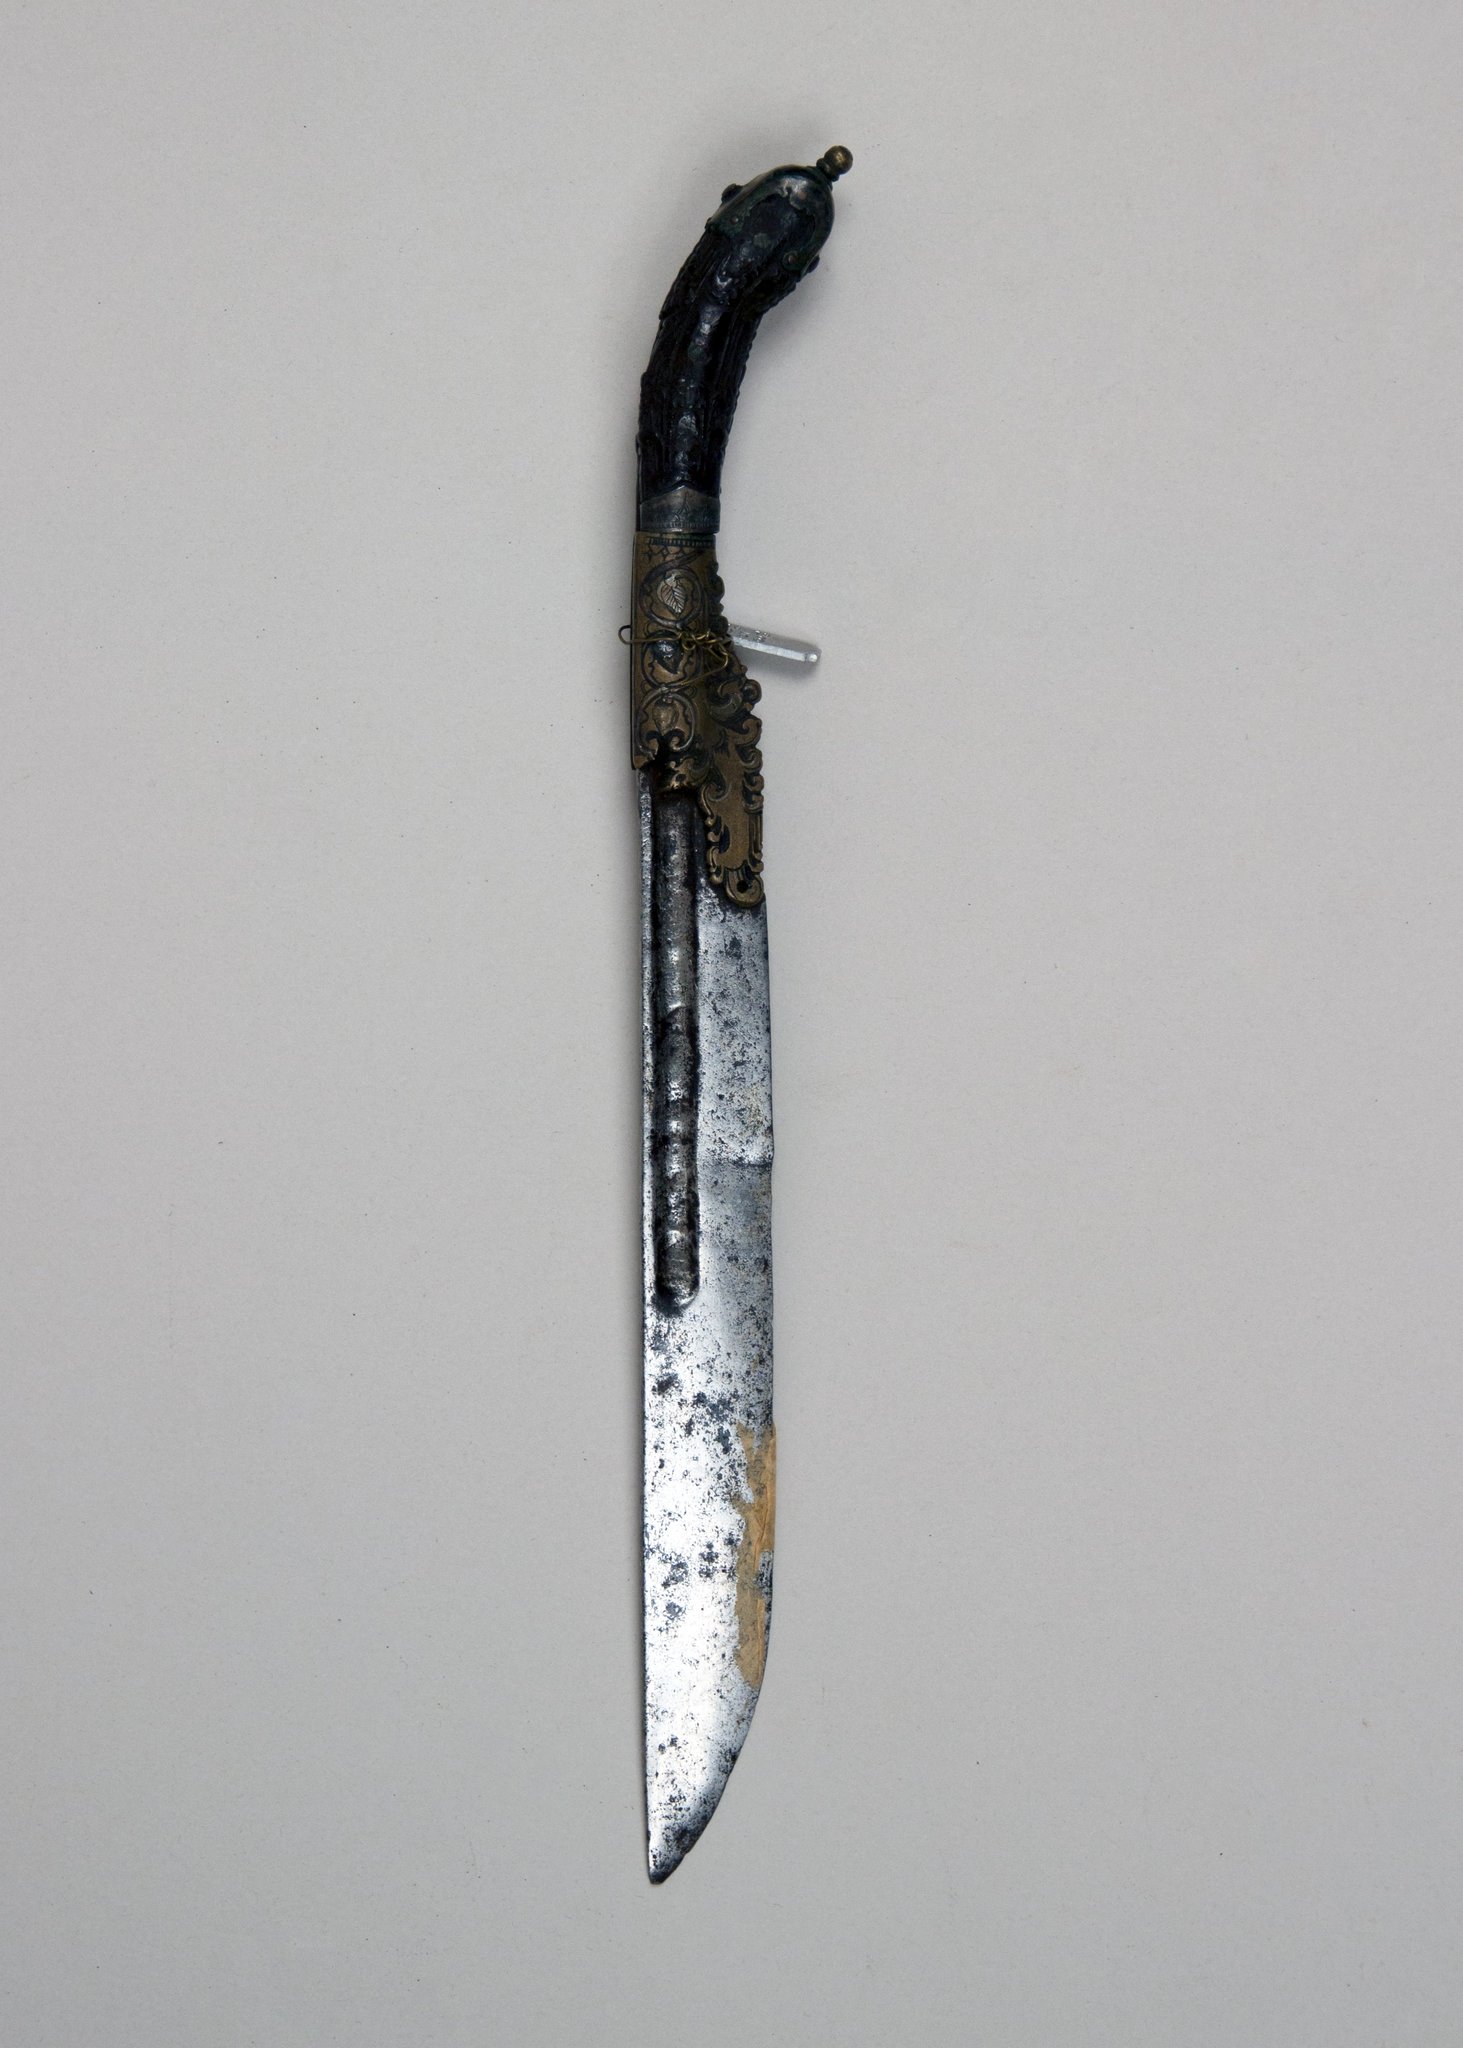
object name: knife piha kaetta with sheath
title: Knife (Piha Kaetta) with Sheath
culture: sri lankan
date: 1701-1900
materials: brass, steel, wood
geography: sri lanka